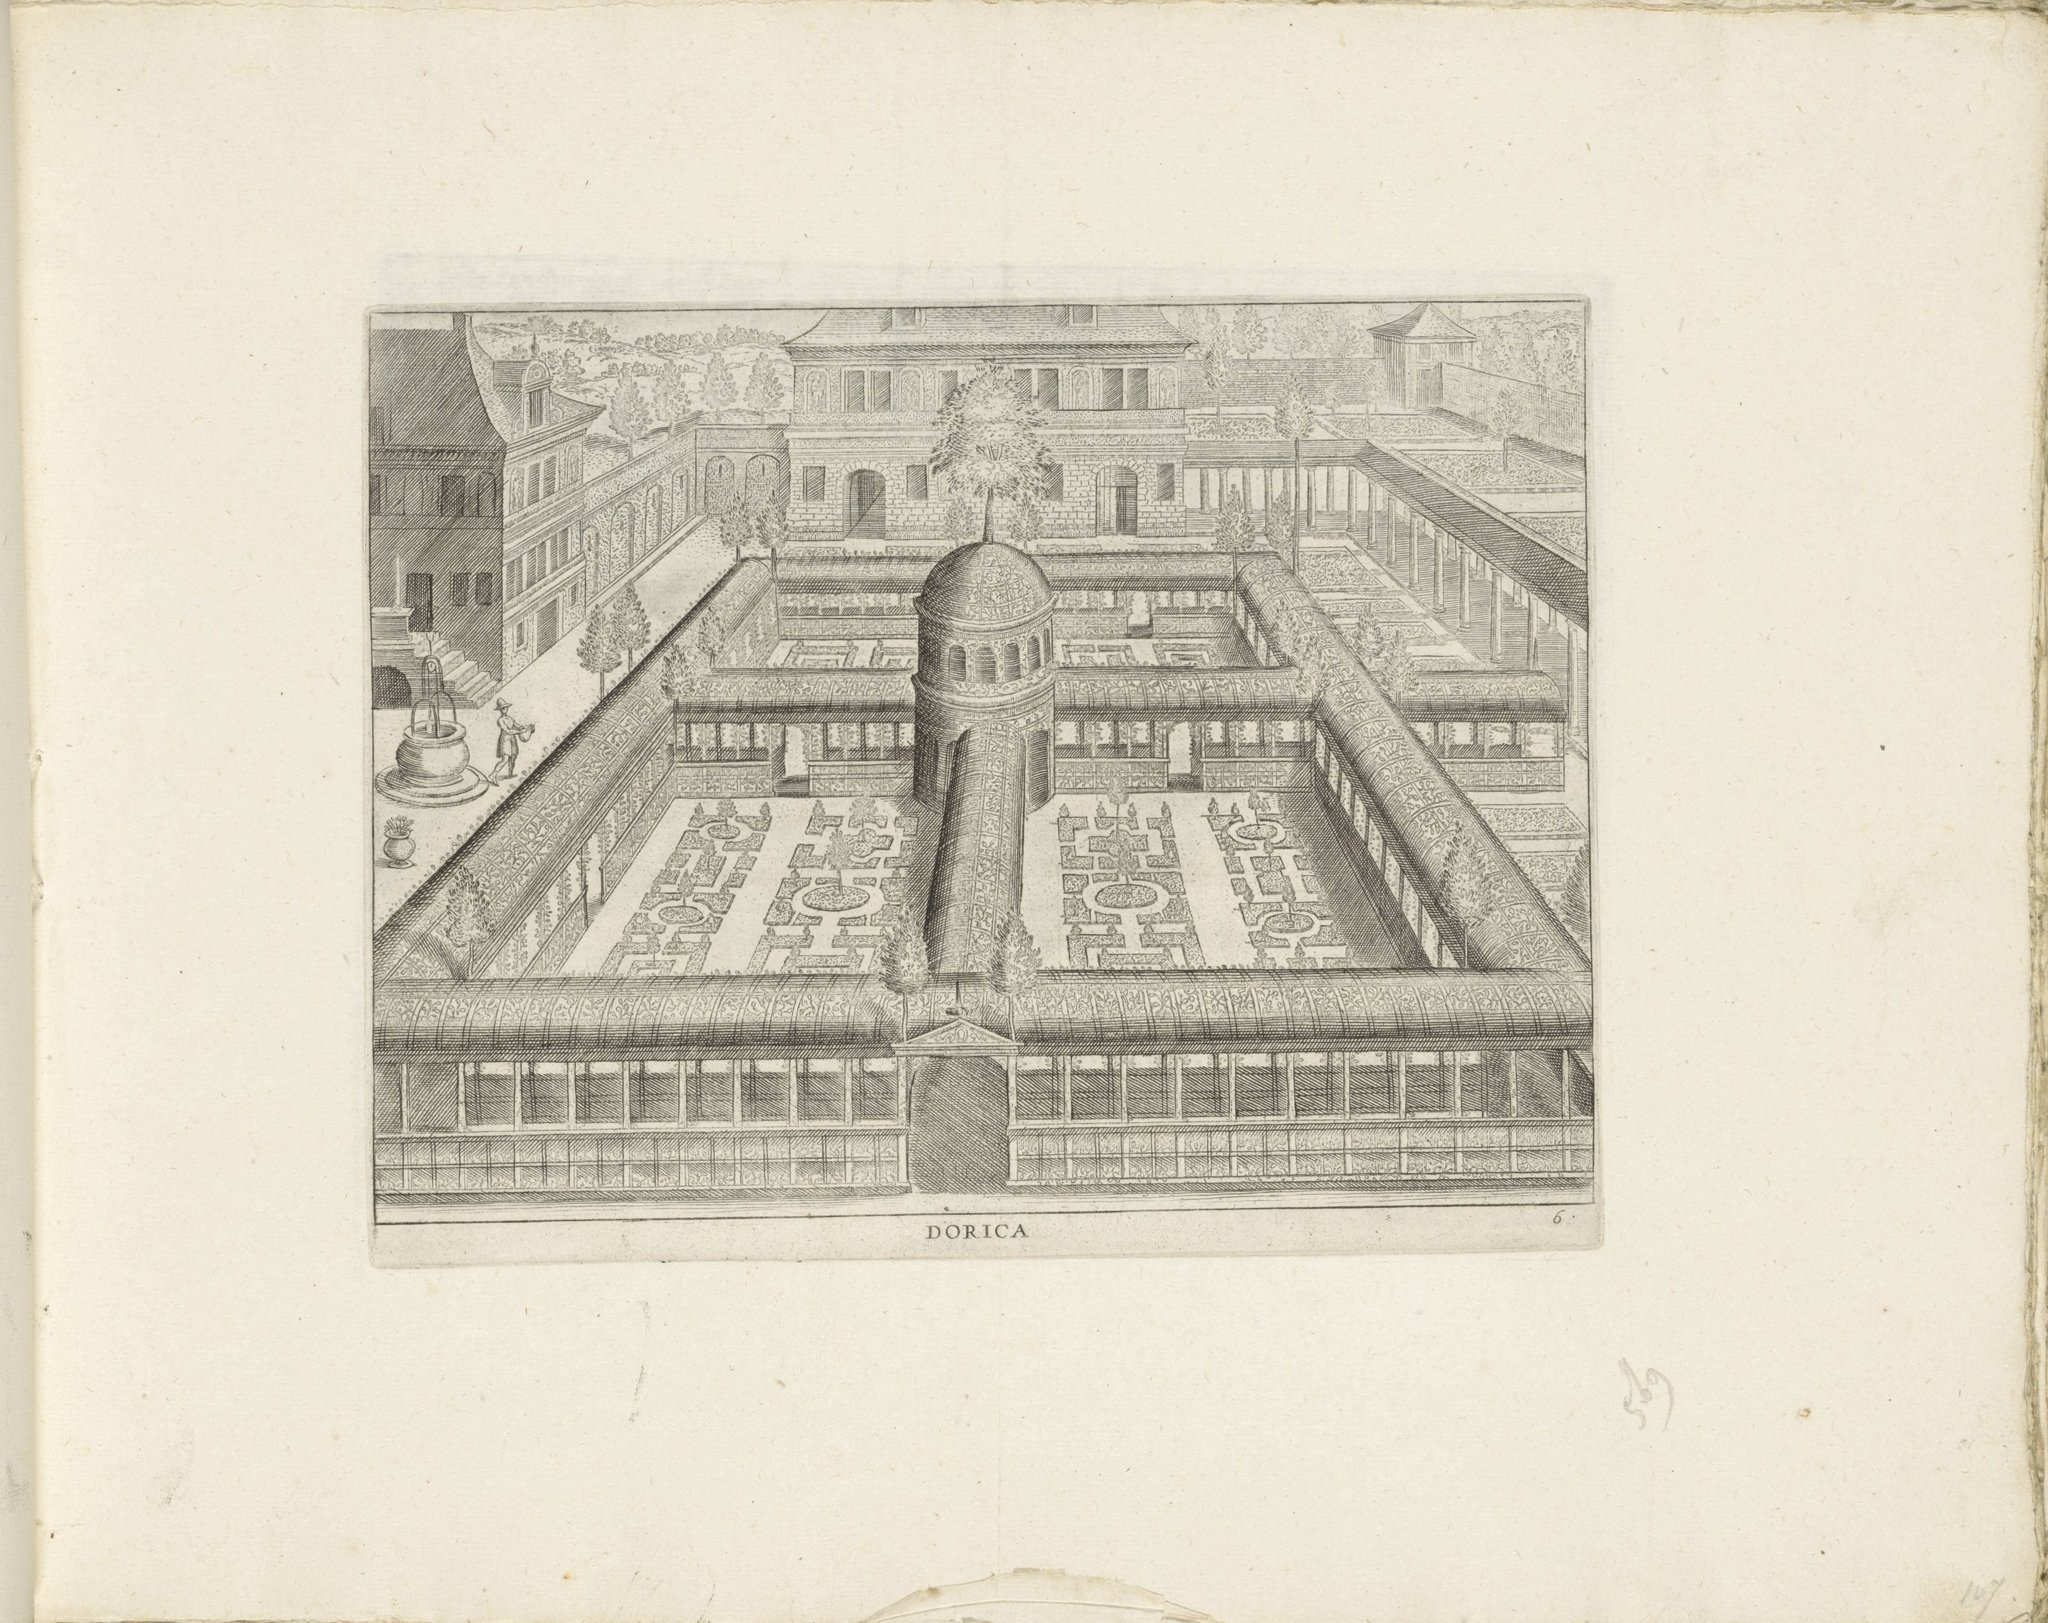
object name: print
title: Tuin met vier door gangen van traliewerk omgeven parterres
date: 1583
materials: paper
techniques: etching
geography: antwerp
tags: garden, french or architectonic garden; formal garden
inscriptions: collector's mark: Lugt 2760, collector's mark: Lugt 2228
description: De serie ‘Hortorum Viridariorumque’ van Vredeman de Vries (Hollstein Dutch 470-490) is in deze editie van de serie door uitgever Joannes Galle ( en eerder door zijn voorganger Theodoor Galle) aangevuld met de serie ‘Tuinen’ van Vredeman de Vries (Hollstein Dutch 508-515) en met twee prenten van Pieter van der Borcht (I) (New Hollstein Dutch 161-162). De prenten zijn genummerd: 1-30. Origineel hoort bij deze editie van de serie, uitgegeven door Joannes Galle, nog een prent van Van der Borcht met nummer 31, maar deze prent ontbreekt in deze serie in de collectie van het Rijksmuseum.